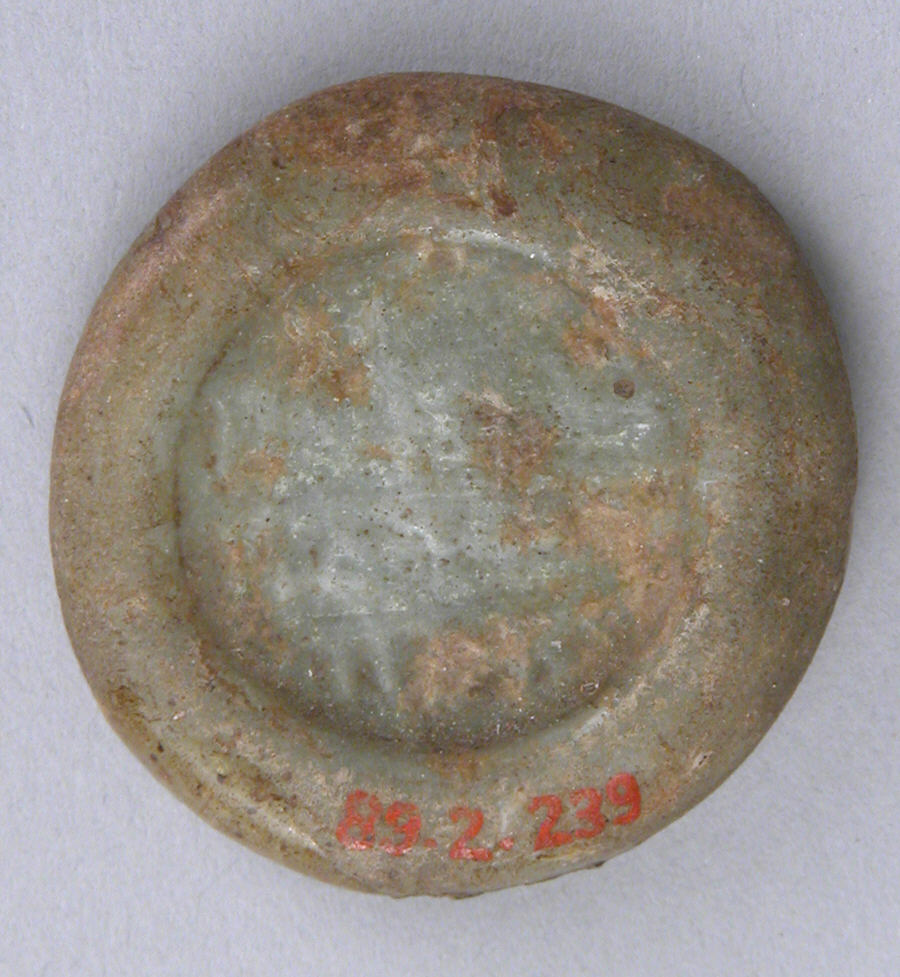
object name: coin weight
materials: glass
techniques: stamping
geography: egypt